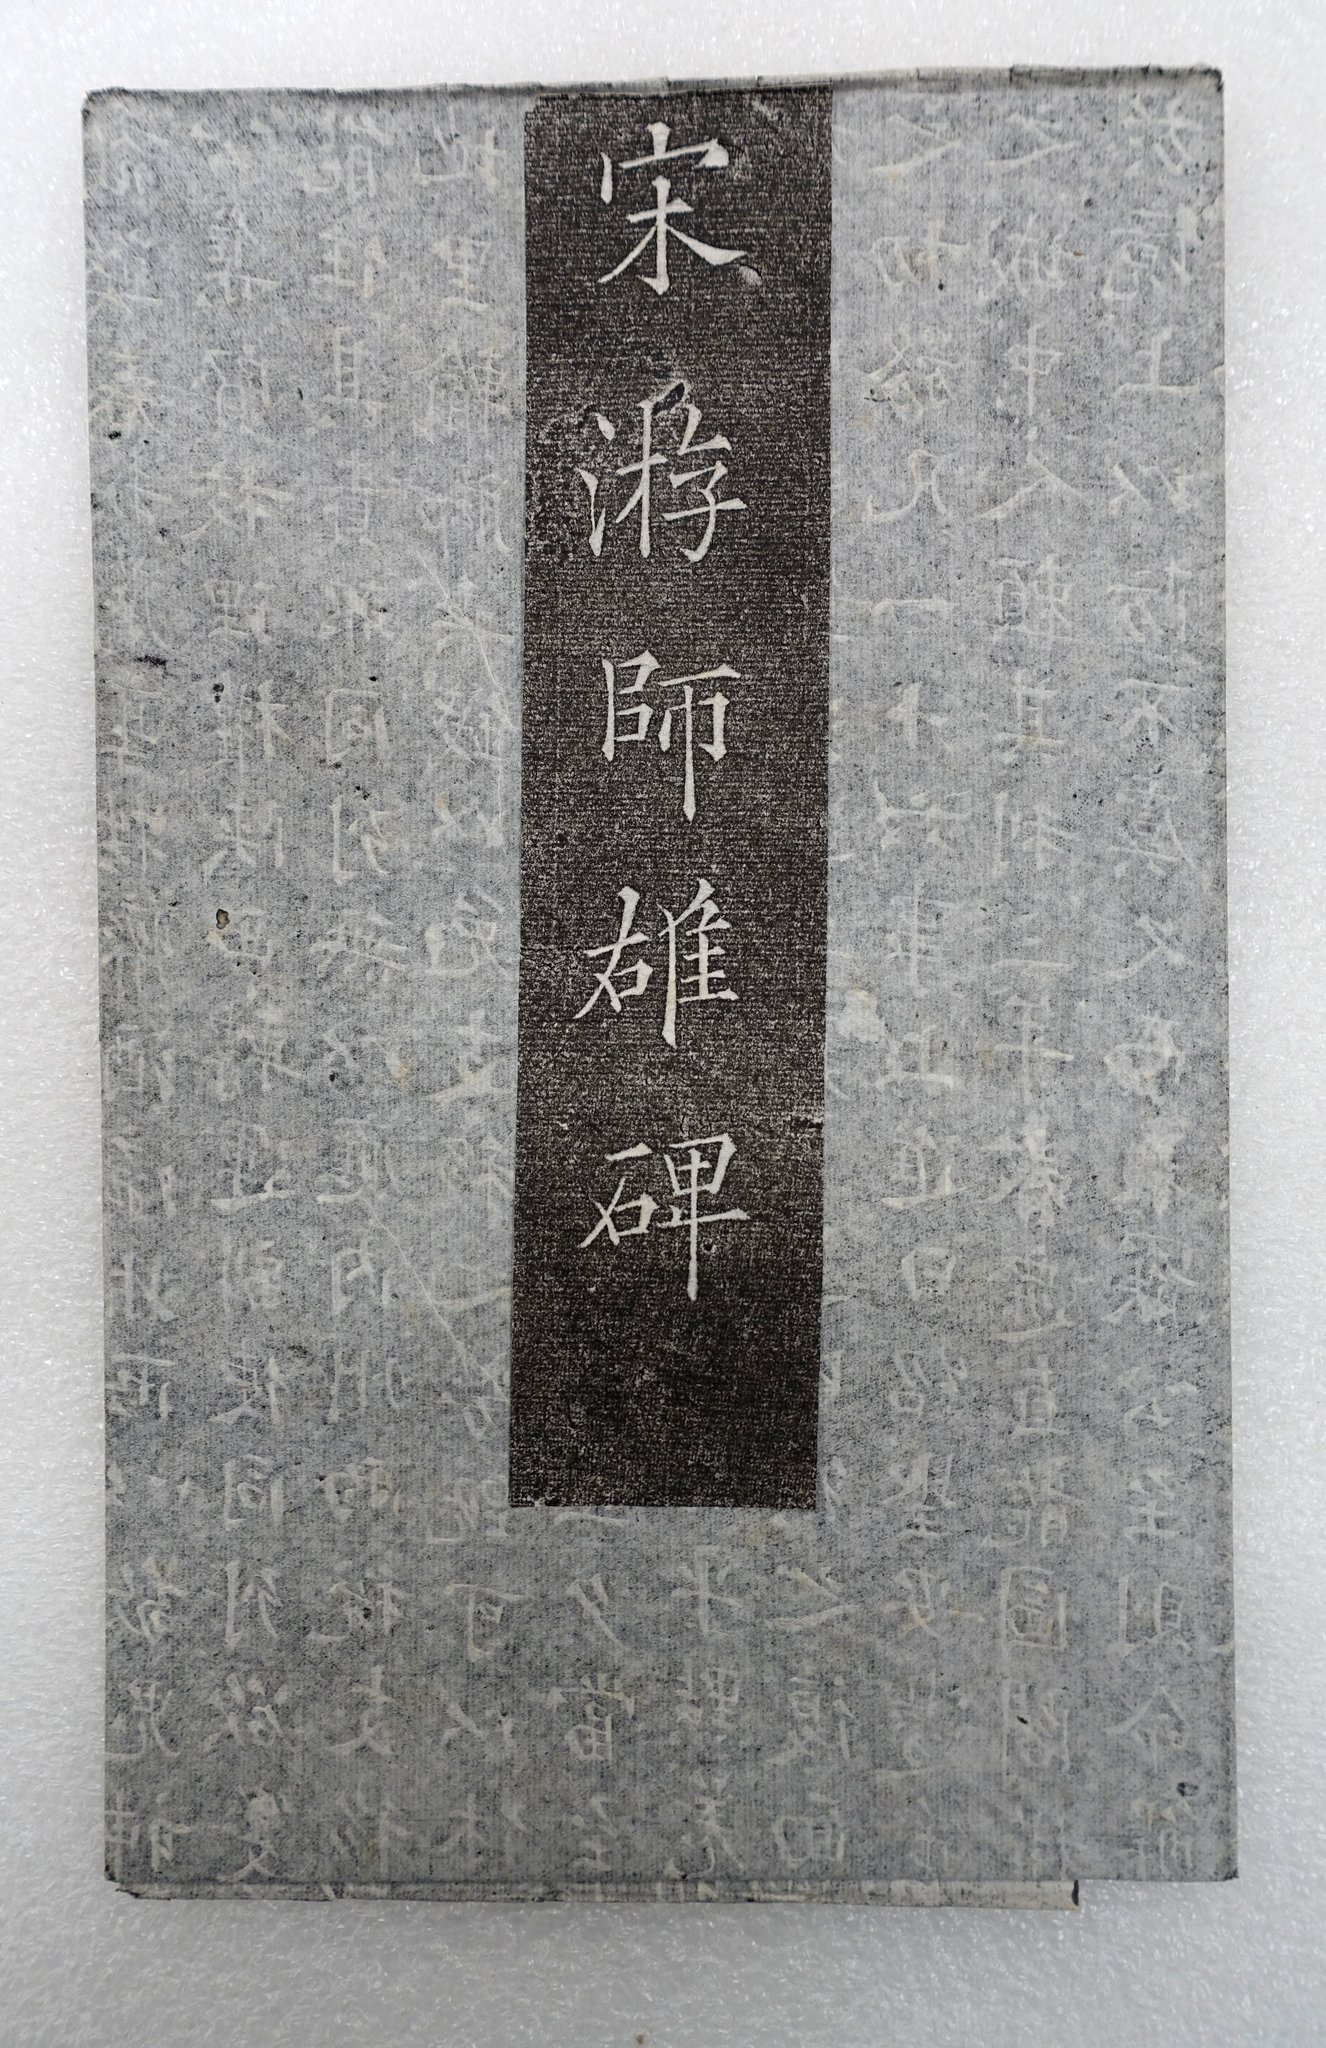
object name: rubbing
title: Epitaph for You Shixiong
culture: chinese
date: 1901-2000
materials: ink, paper